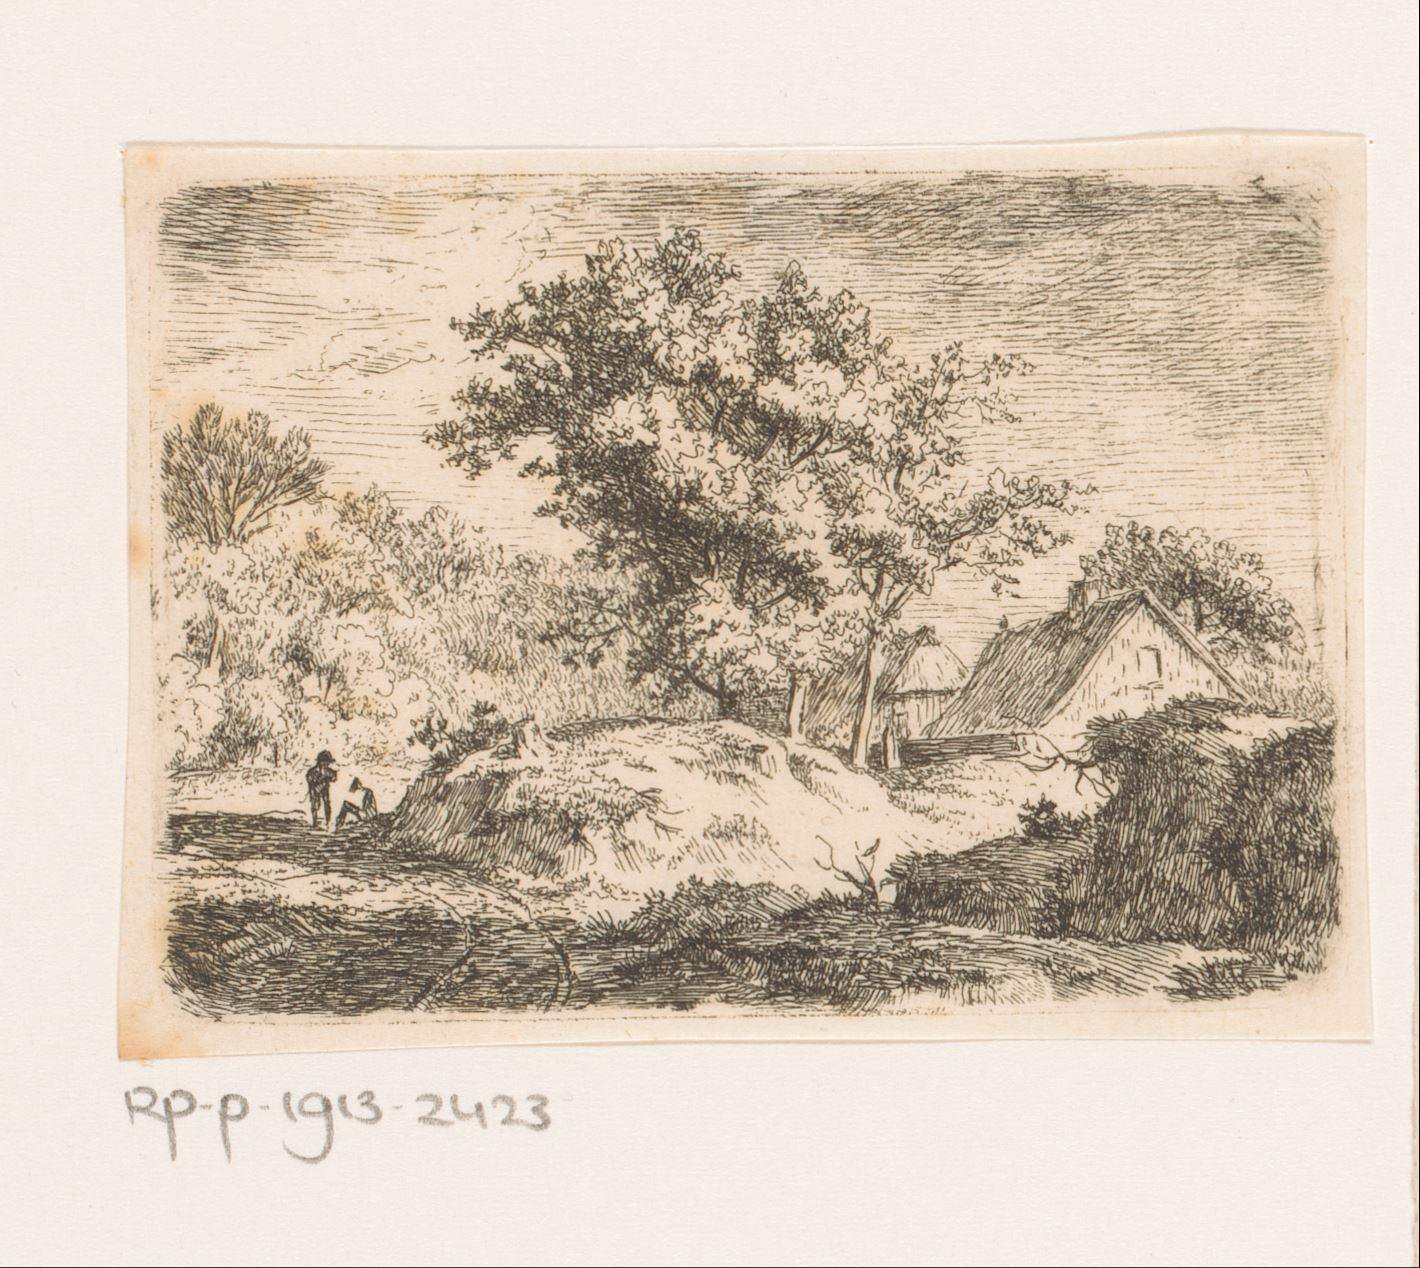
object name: print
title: Landschap met twee figuren in de schaduw van een heuvel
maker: hendrik jozef franciscus van der poorten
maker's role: draughtsman, print maker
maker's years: 1789-1874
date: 1841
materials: paper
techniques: etching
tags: farm or solitary house in landscape, mound, verge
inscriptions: collector's mark: Lugt 2228